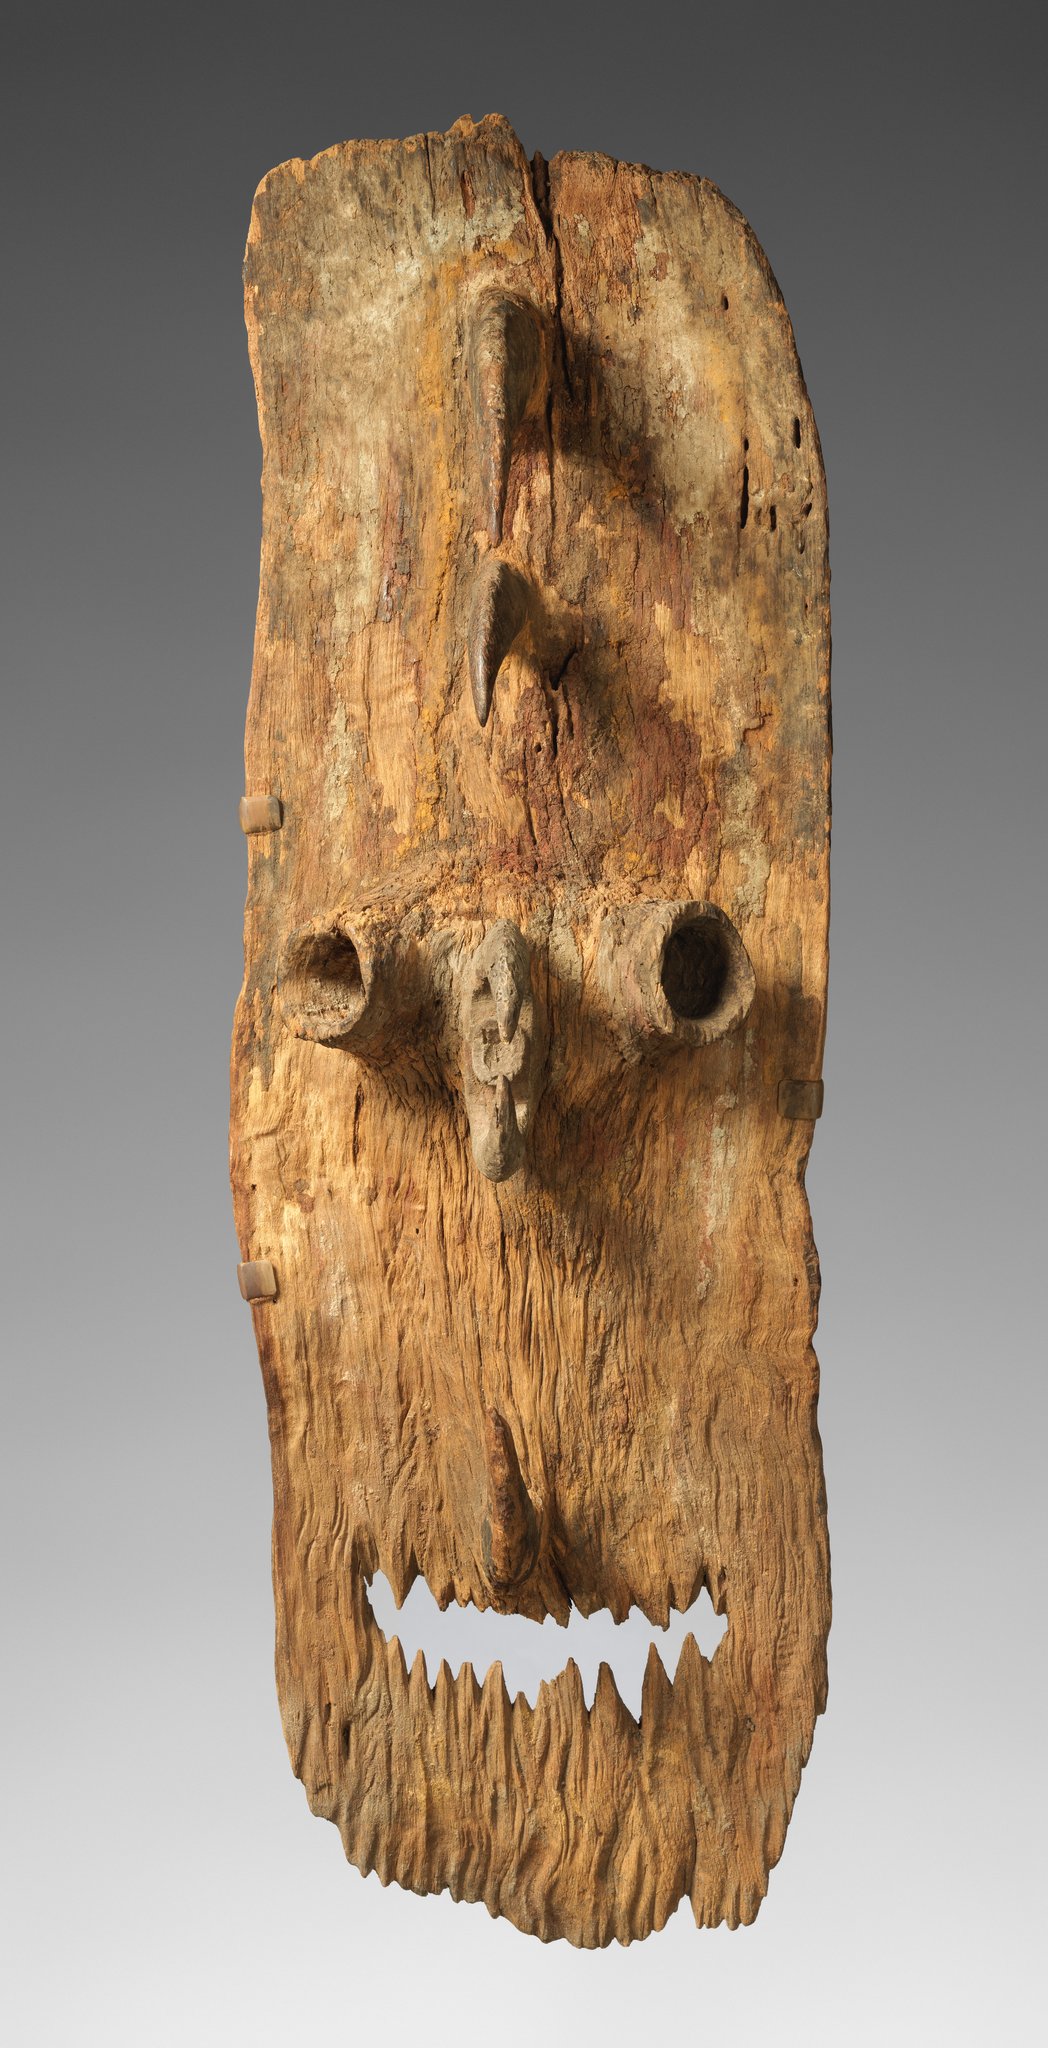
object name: mask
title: Hook-Mask (Garra or Gra)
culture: bahinemo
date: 1801-1900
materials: pigment, wood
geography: papua new guinea